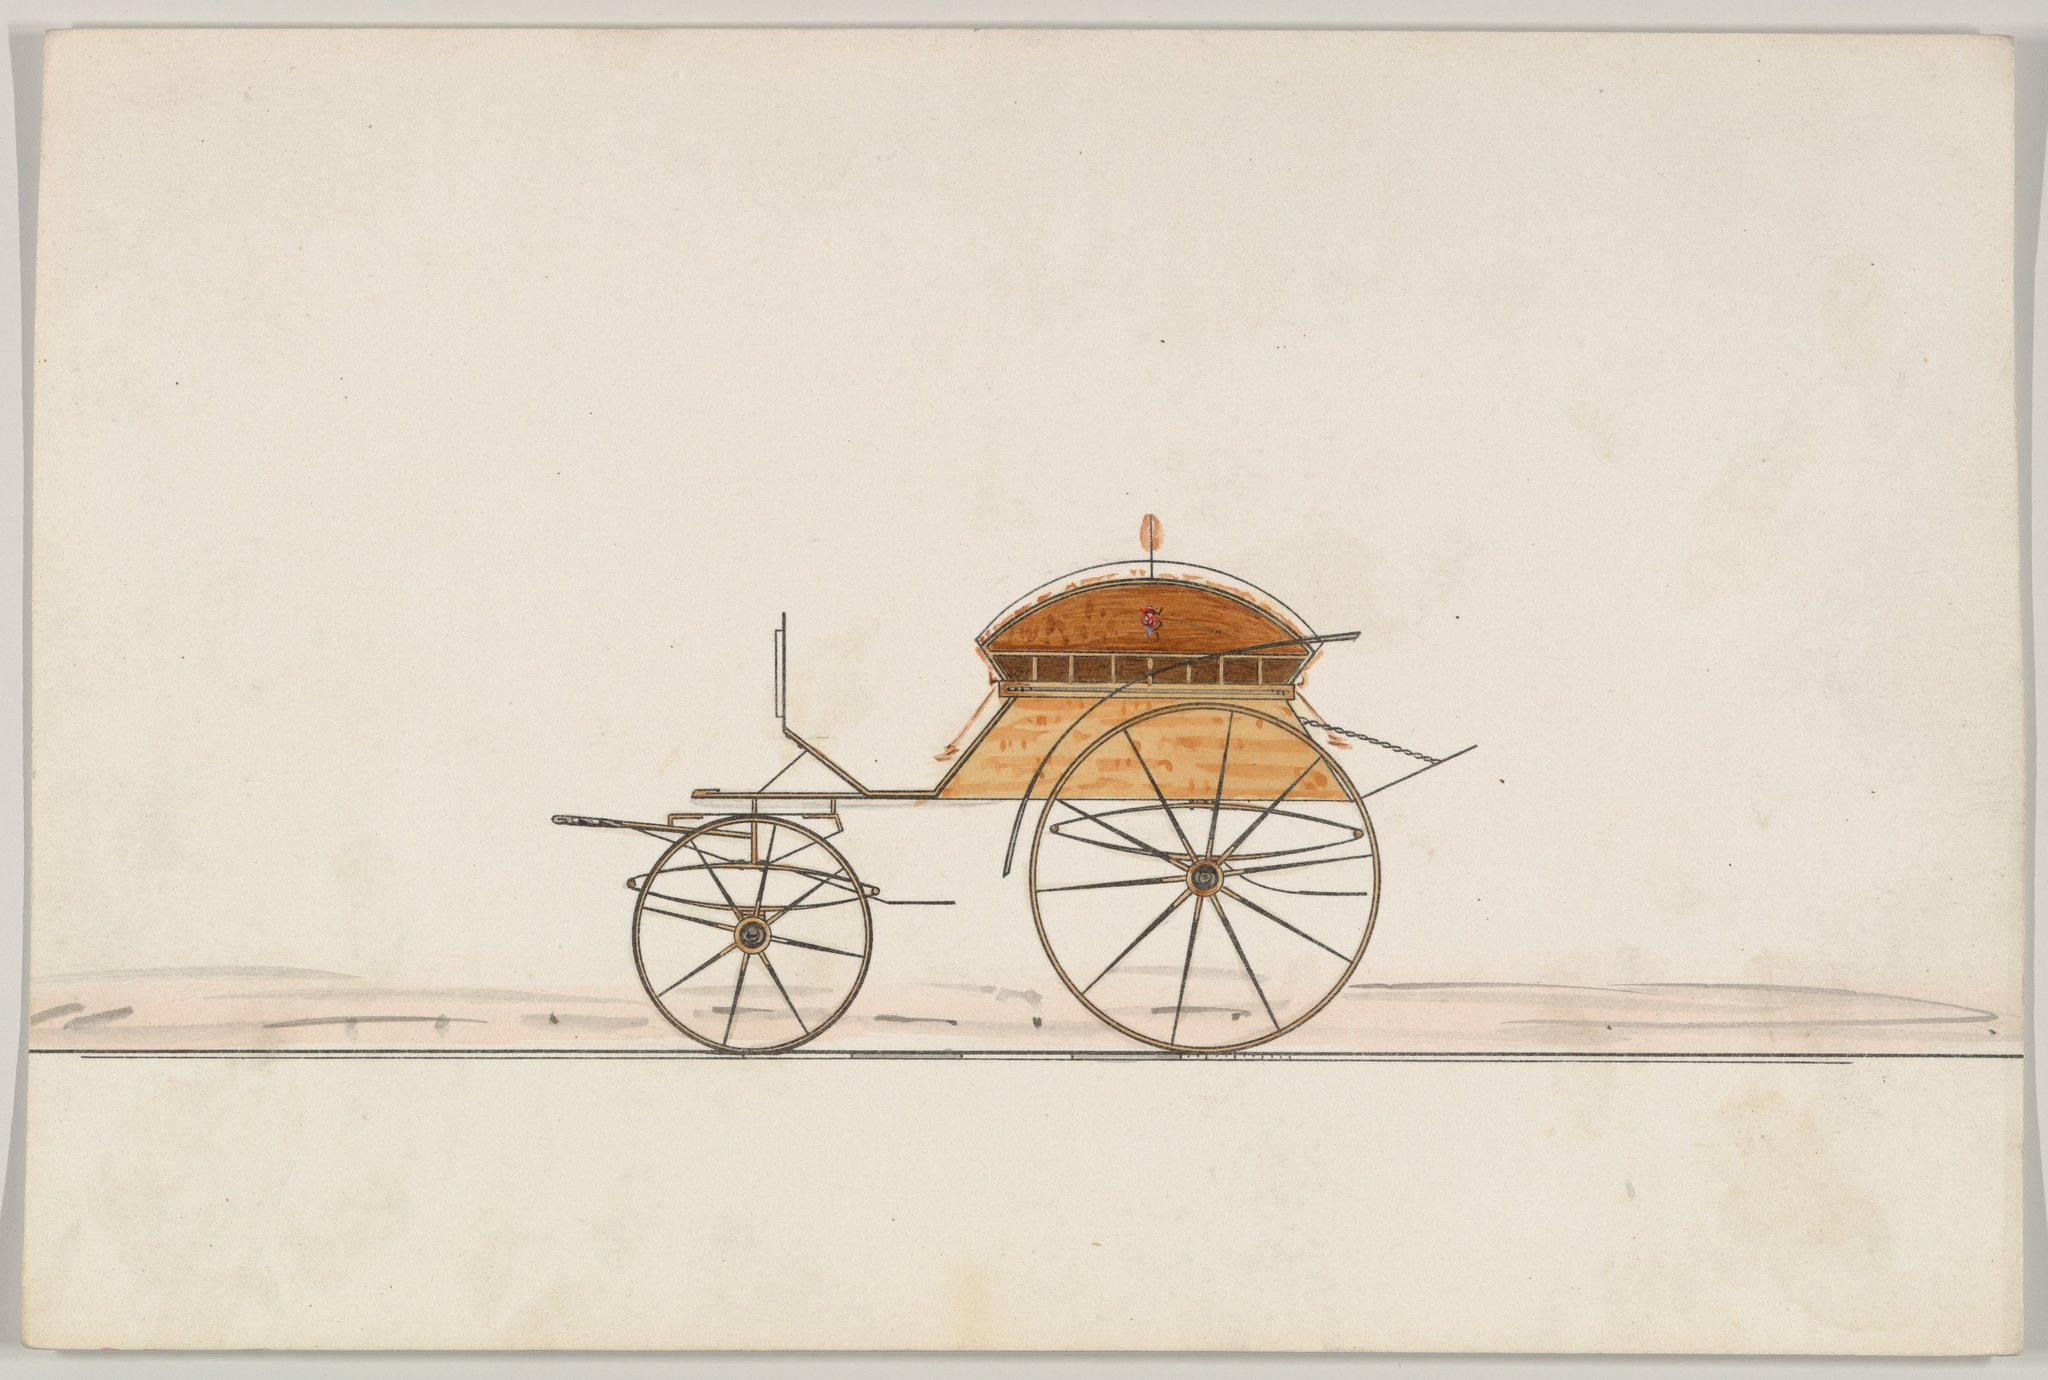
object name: drawing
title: Design for Dos-à-dos Phaeton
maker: brewster & co.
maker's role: manufacturer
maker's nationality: american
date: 1850-1870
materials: gouache, gum arabic, ink, watercolor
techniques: pen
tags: carriages